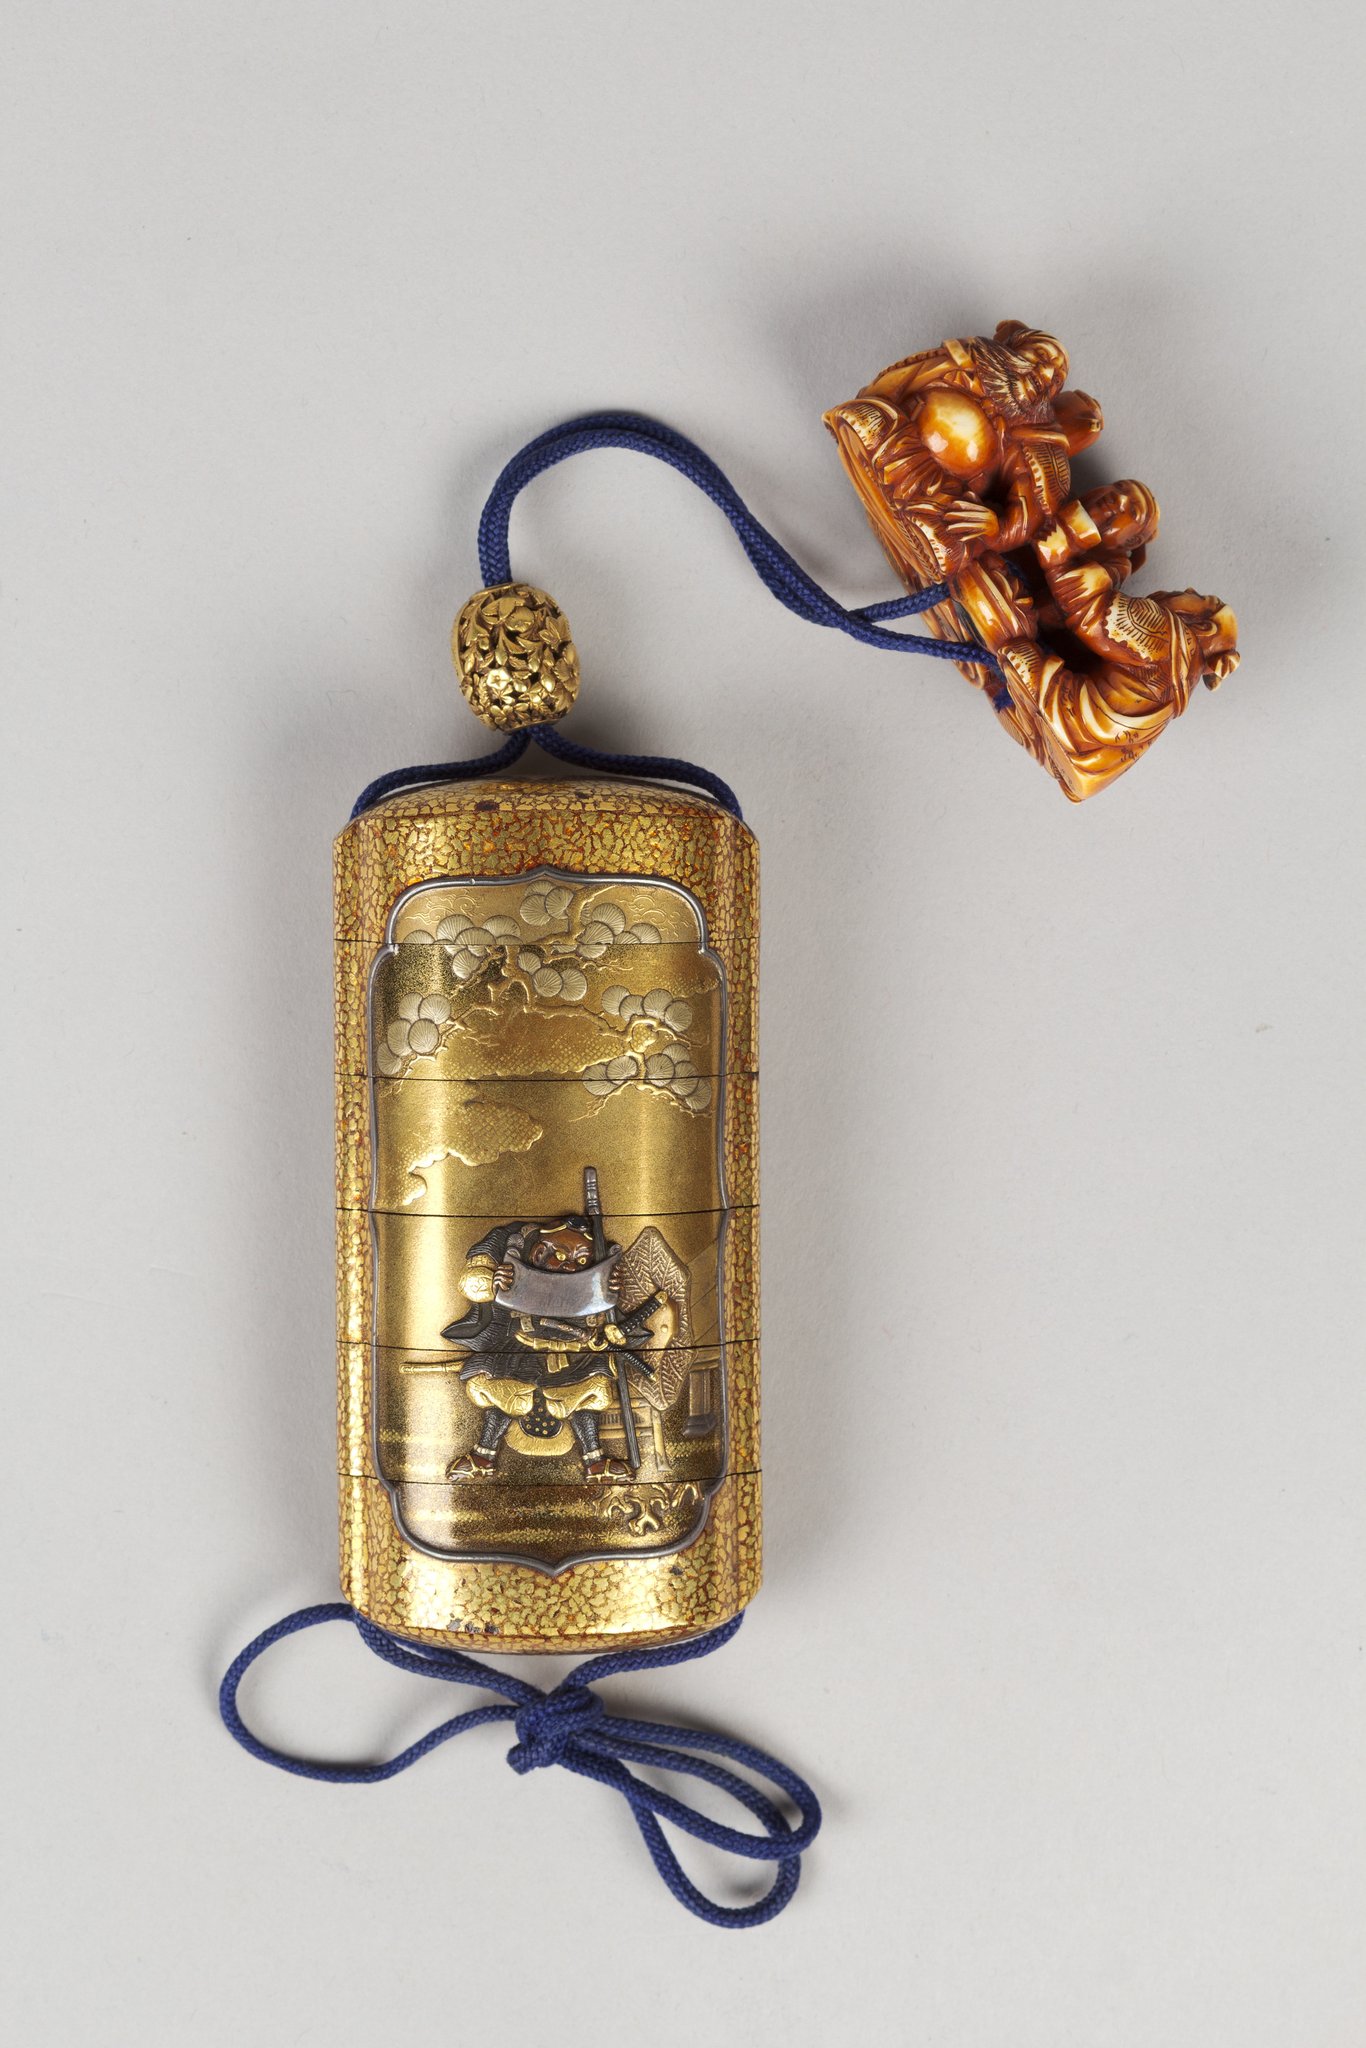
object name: inrō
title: Case (Inrō) with Design of Daimyo Seated on a Platform (obverse); Warrior Reading a Scroll (reverse)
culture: japanese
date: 1801-1900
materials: gold, lacquer, metal, silver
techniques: fundame, hiramakie, inlay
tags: scrolls,men,reading